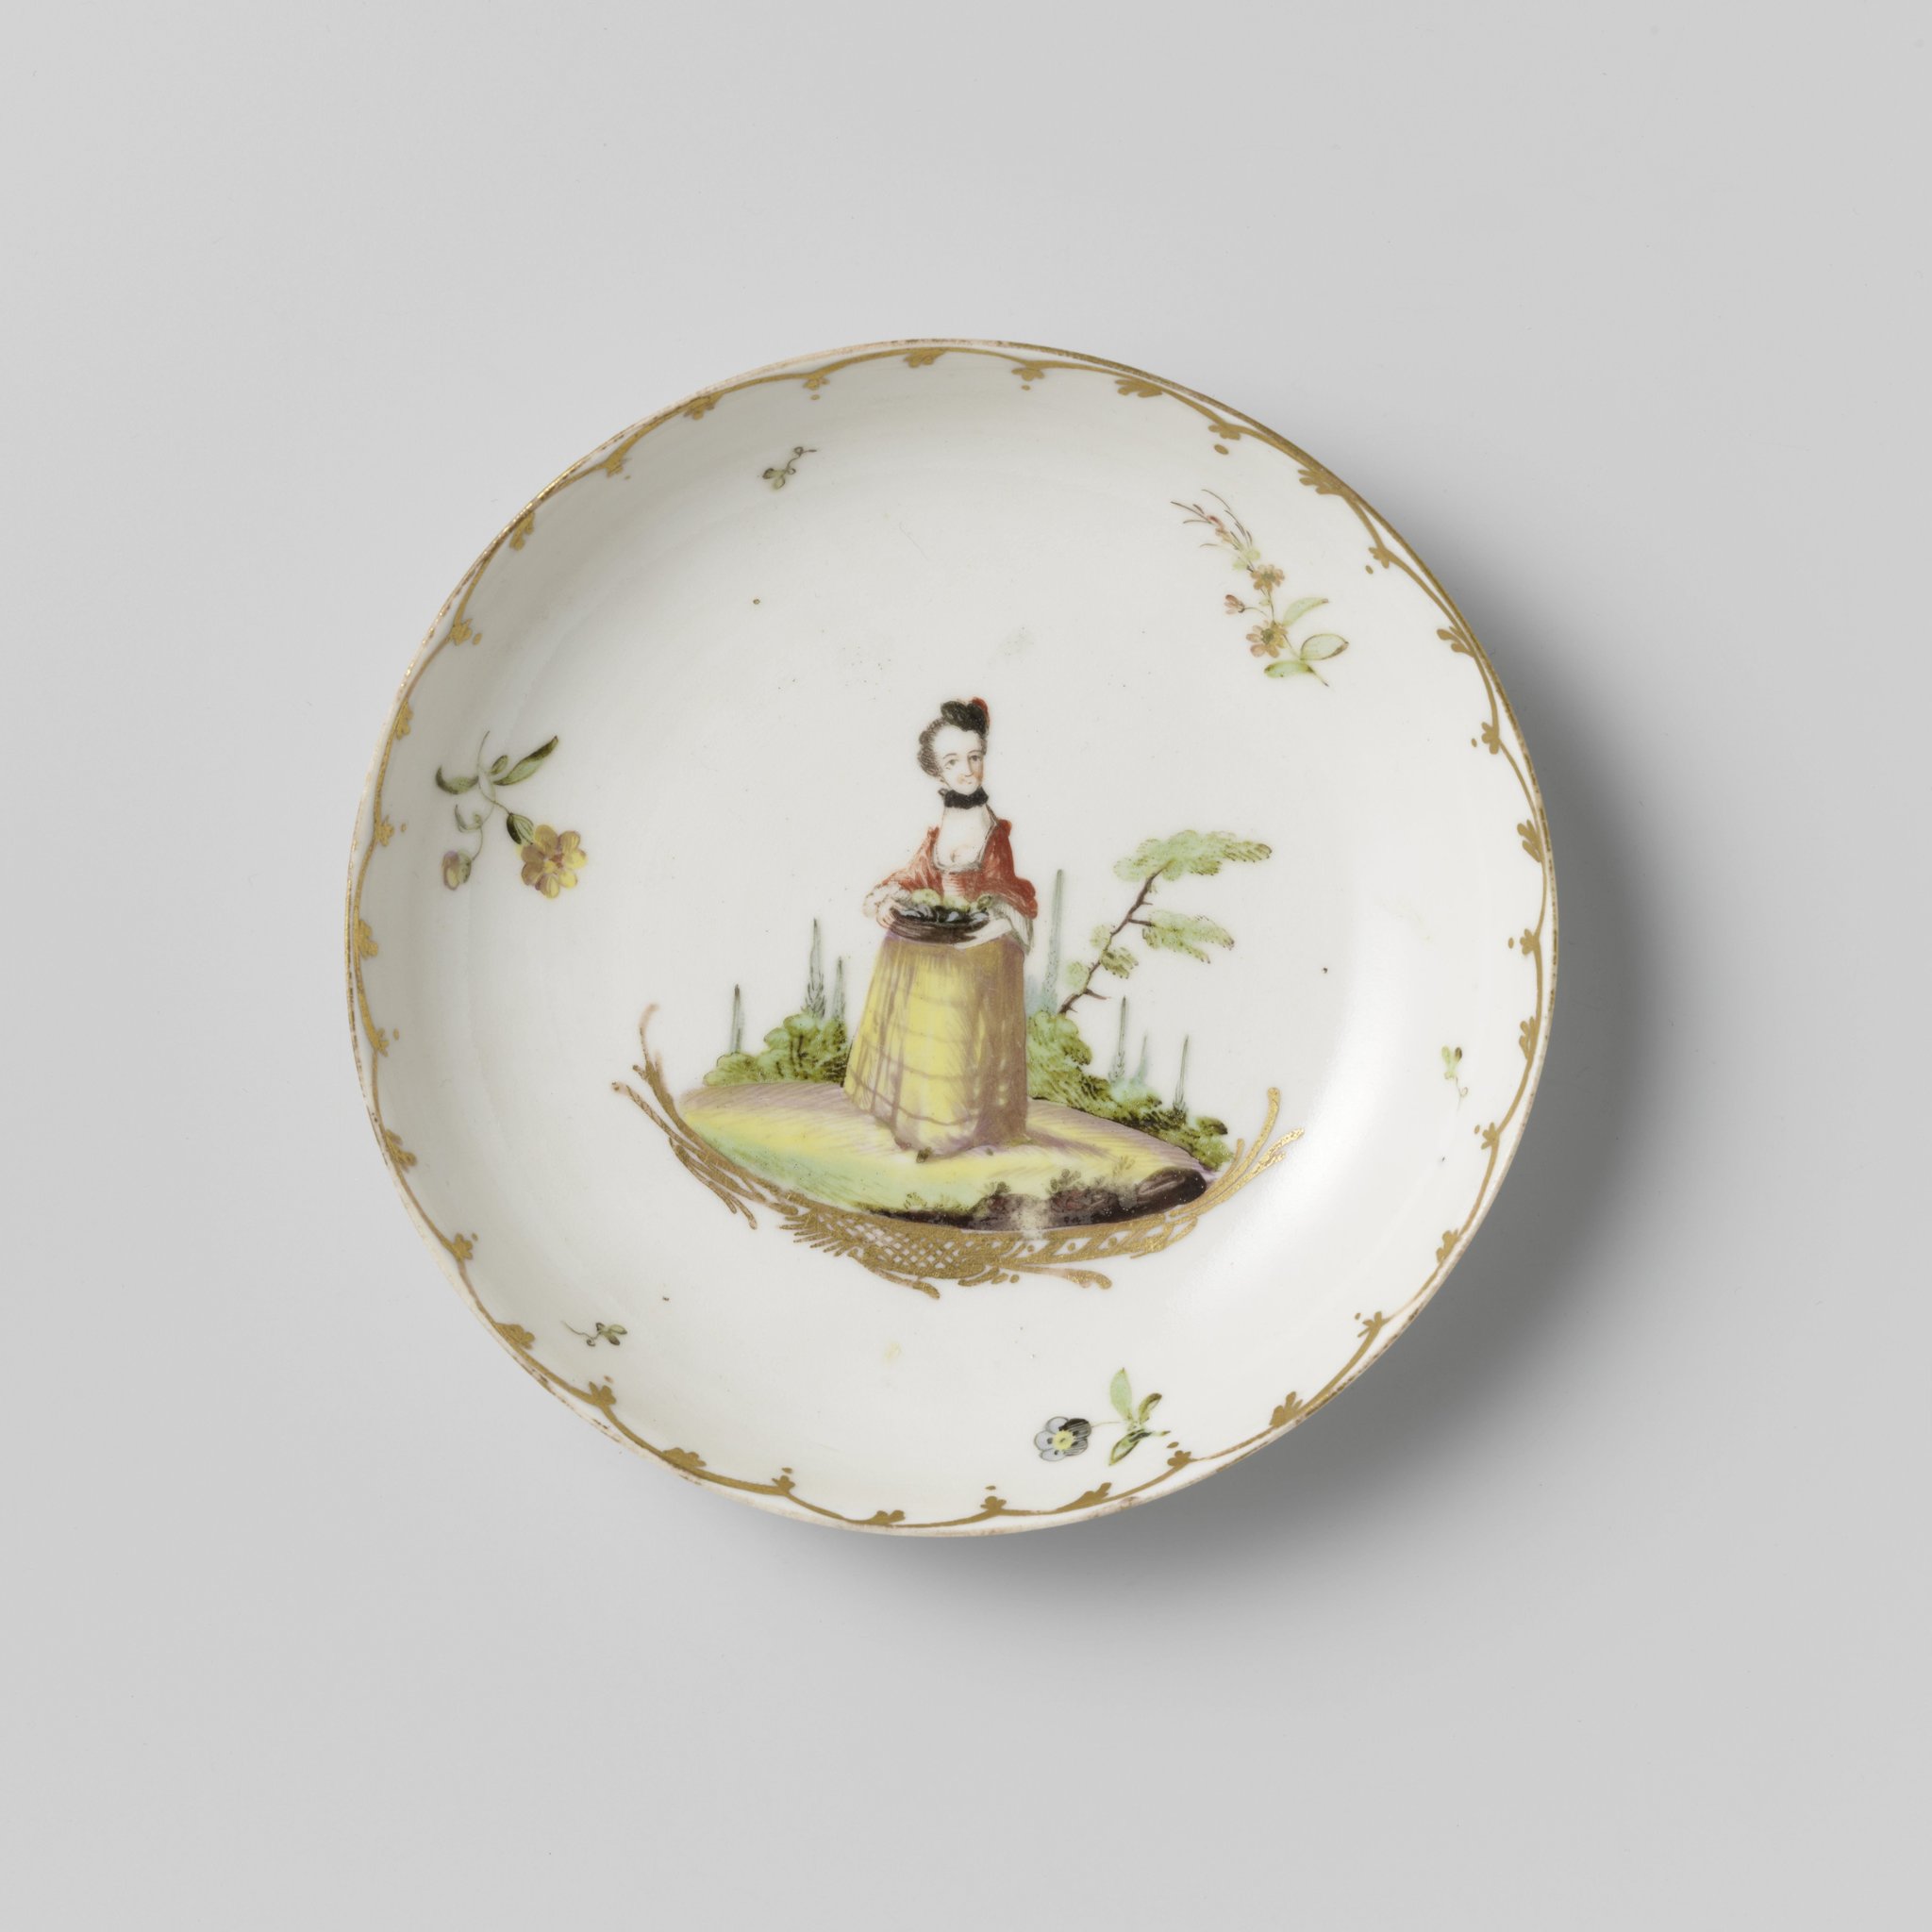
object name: platter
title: Schotel, beschilderd met figuren in landschappen. Onderdeel van een servies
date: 1759-1771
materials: porcelain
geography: weesp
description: Schotel van porselein, veelkleurig beschilderd met figuren in landschappen. Onderdeel van een servies. Gemerkt met twee gekruiste zwaarden en ingegrift: MHS.